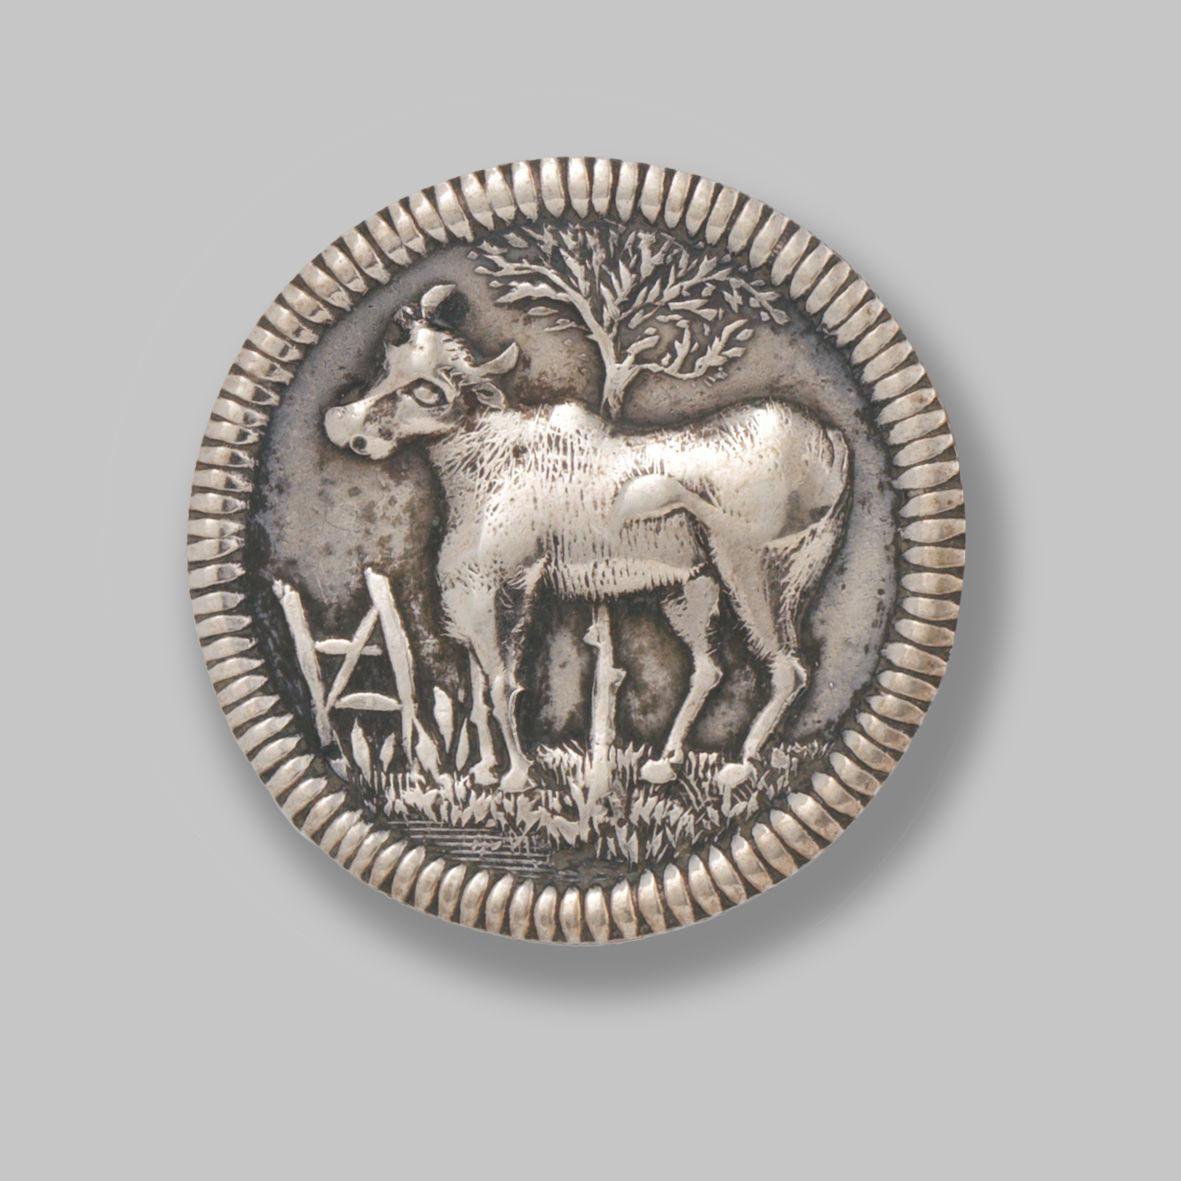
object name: button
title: Knoop met voorstelling van een koe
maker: Anonymous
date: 1850-1900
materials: silver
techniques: casting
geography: netherlands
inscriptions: alloy mark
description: Knoop van gegoten zilver, rond, met op de voorzijde een koe in een weiland omgeven door een geribde rand. Aan de achterzijde is een uit gebogen draad vervaardigd oog bevestigd.